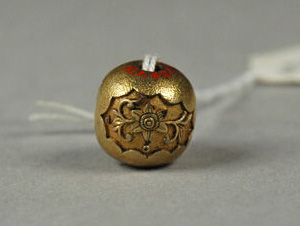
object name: ojime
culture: japanese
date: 1801-1900